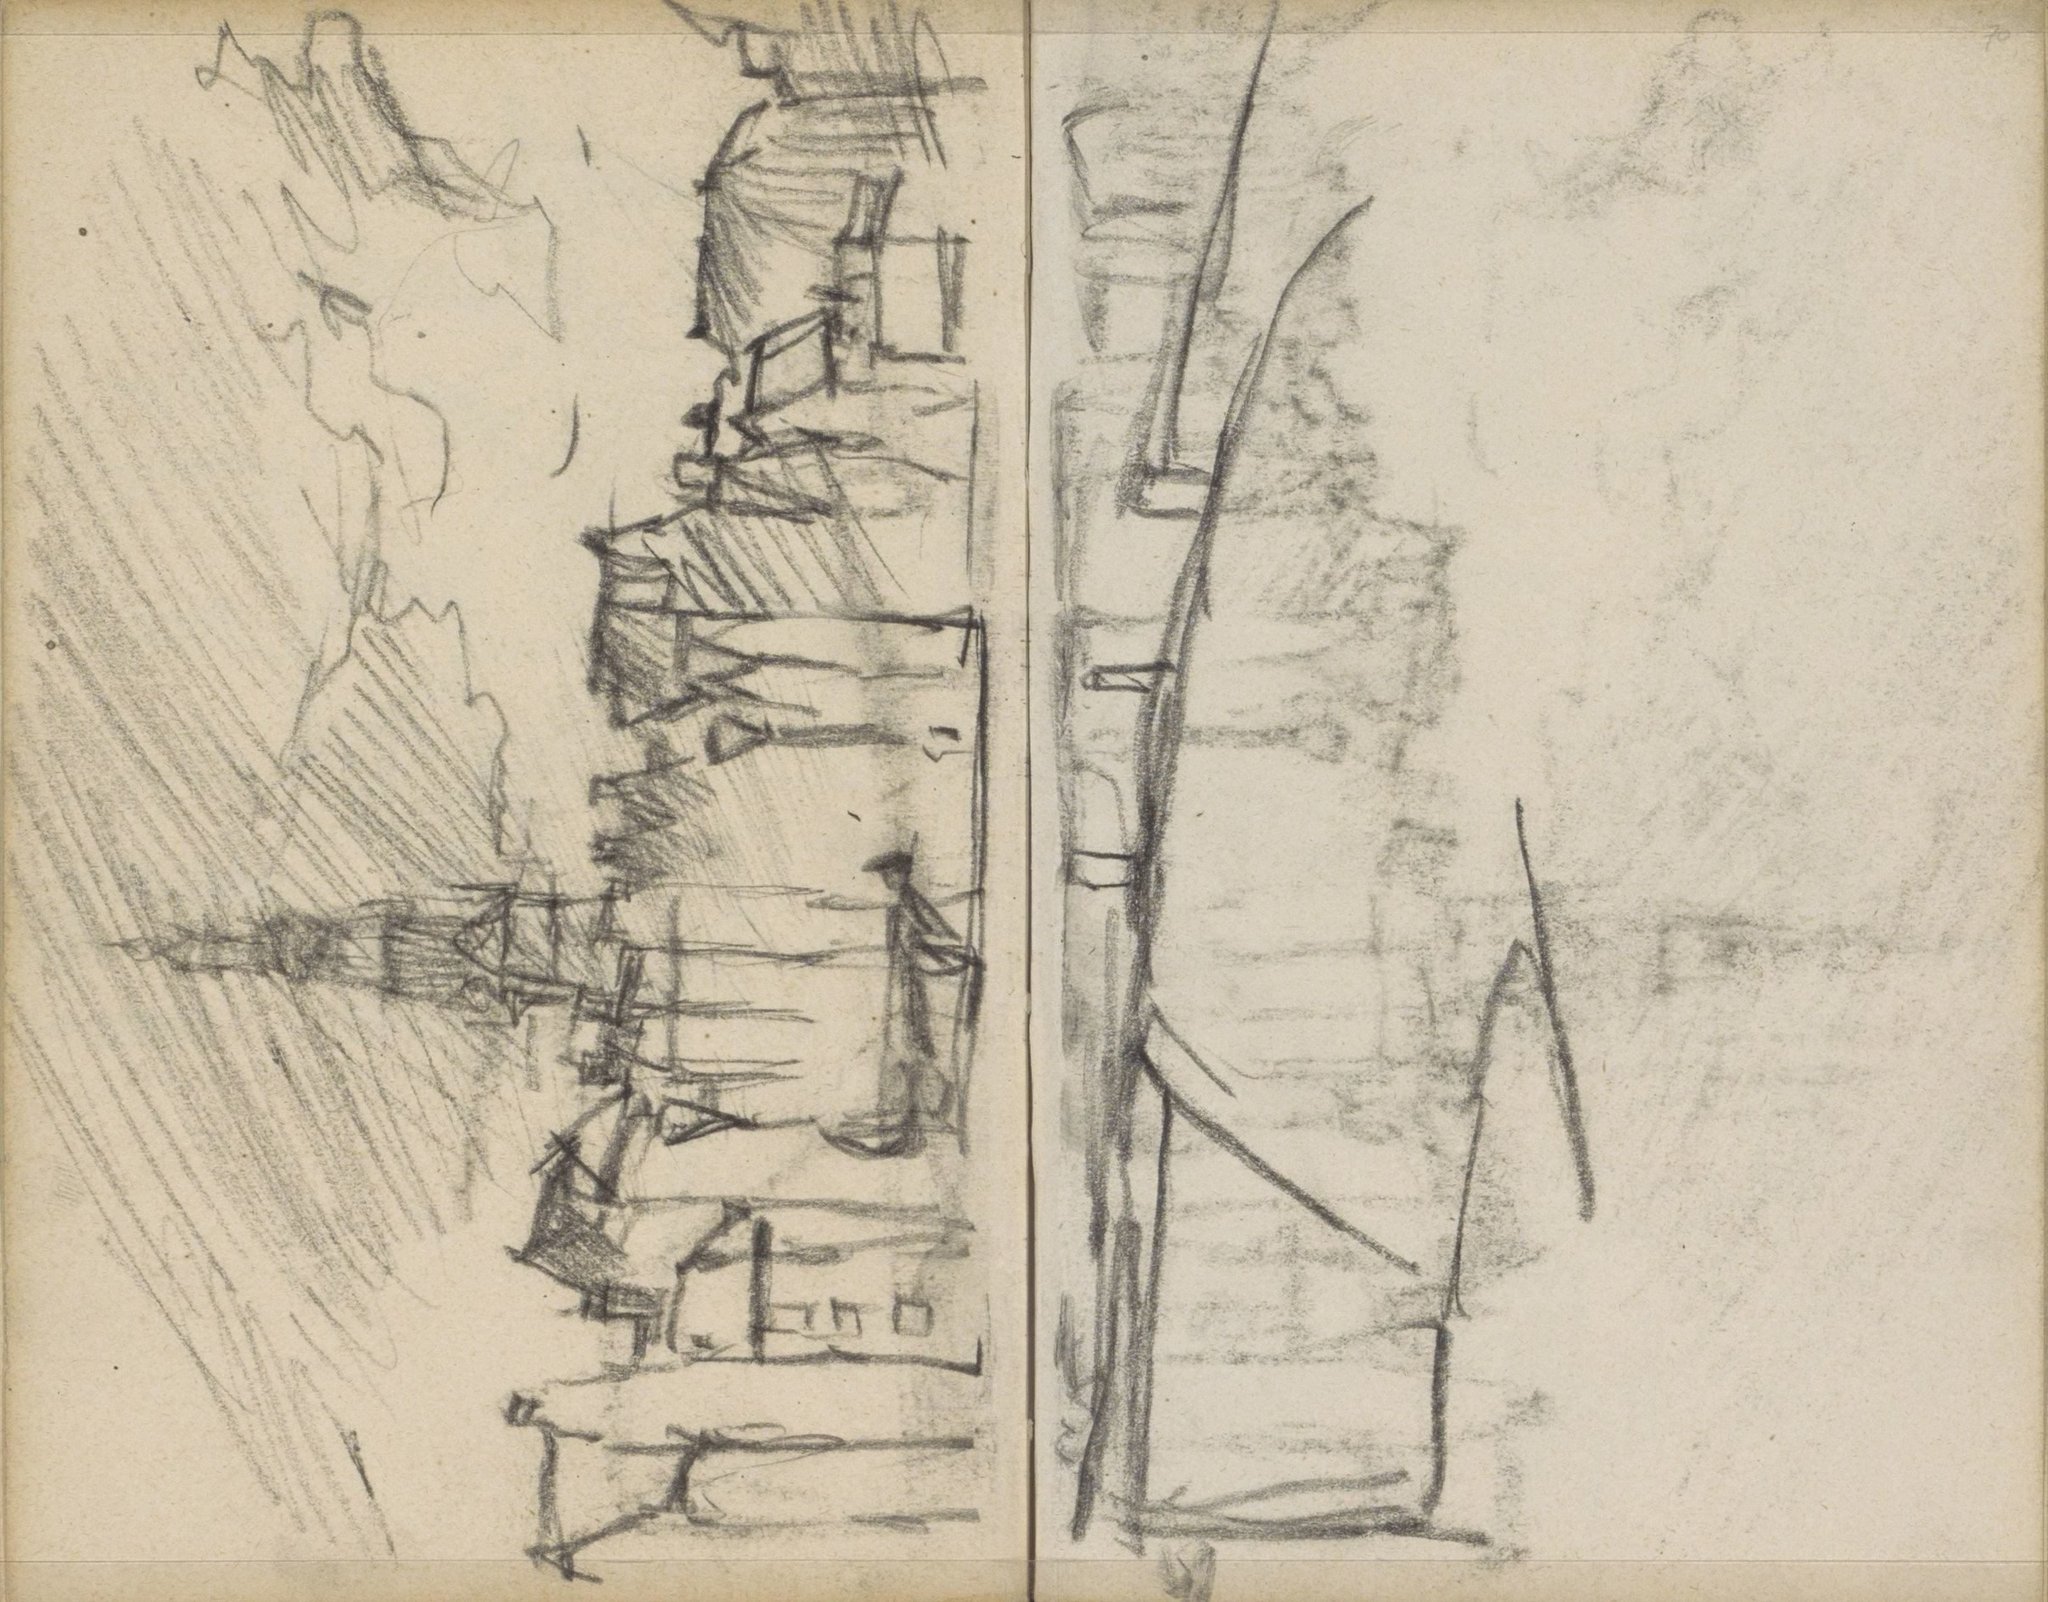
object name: sketchbook leaf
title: Gezicht op het Damrak met de Oude Kerk te Amsterdam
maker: george hendrik breitner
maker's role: draughtsman, painter, print maker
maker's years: 1857-1923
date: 1907-1909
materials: chalk, paper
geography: amsterdam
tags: city-view, and landscape with man-made constructions, parts of church exterior and annexes: tower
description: Gezicht op het Damrak met de toren van de Oude Kerk te Amsterdam. Pagina 69 en pagina 70 uit een schetsboek met 46 bladen vervaardigd te Antwerpen, Gent en Amsterdam.